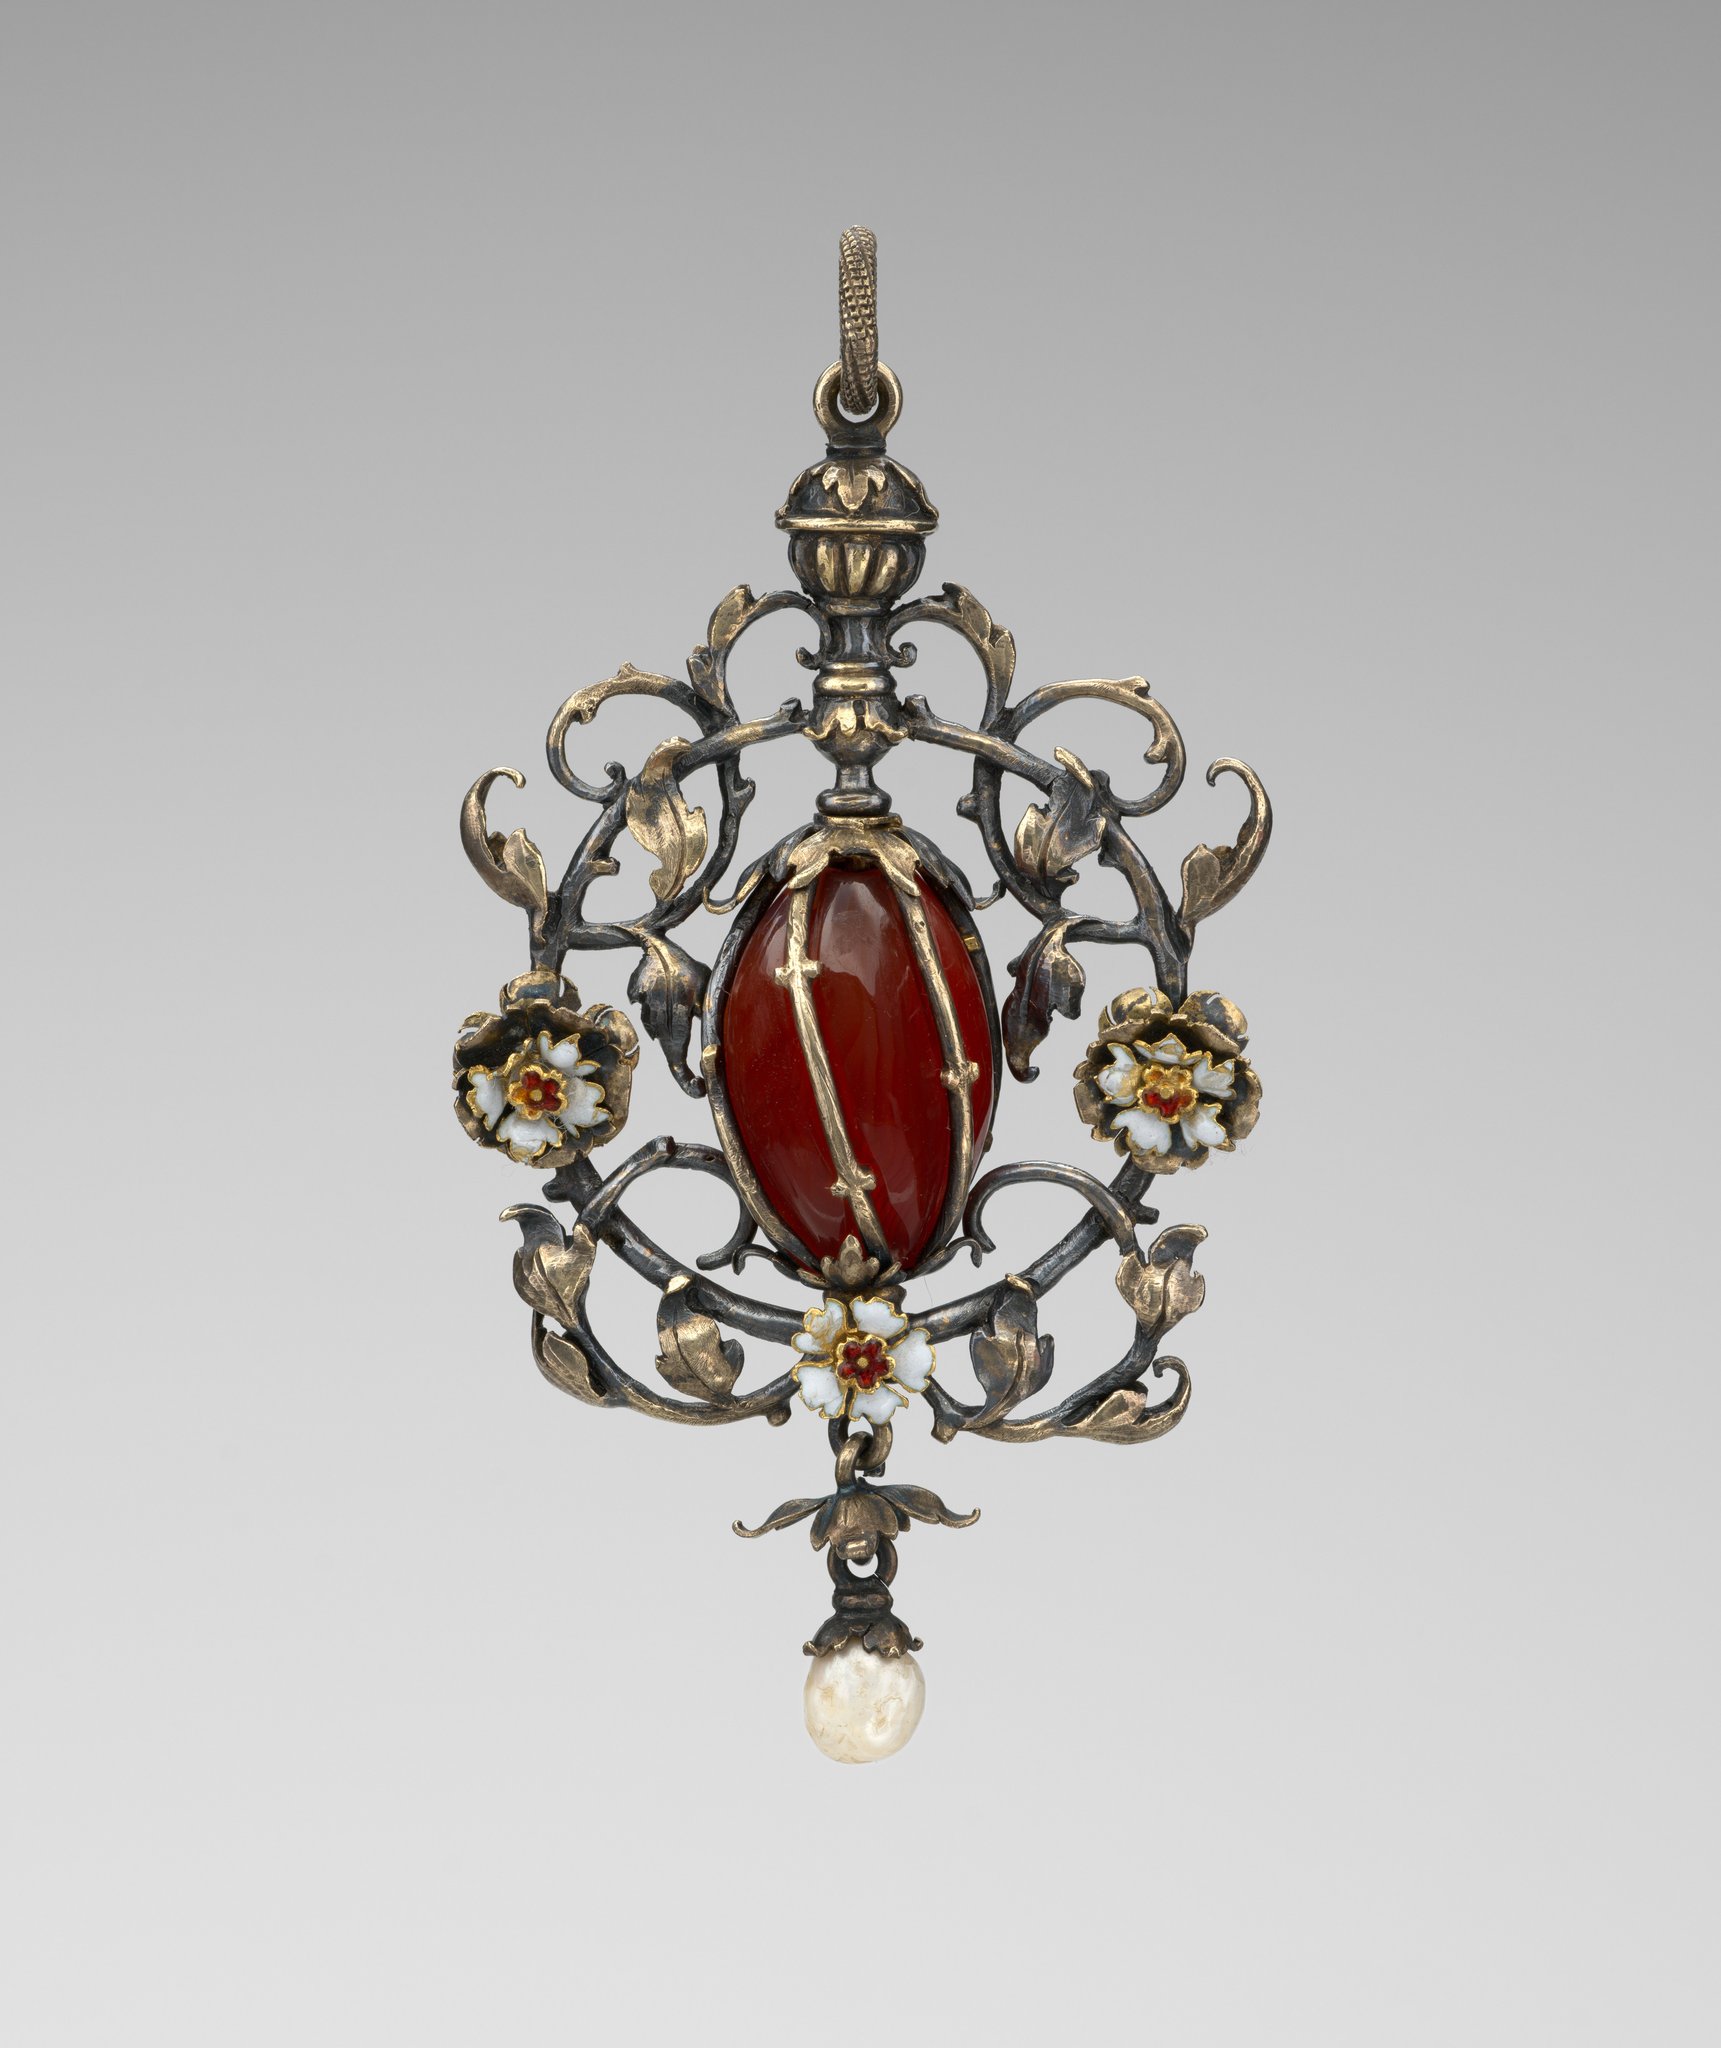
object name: pendant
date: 1801-1900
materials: silver gilt